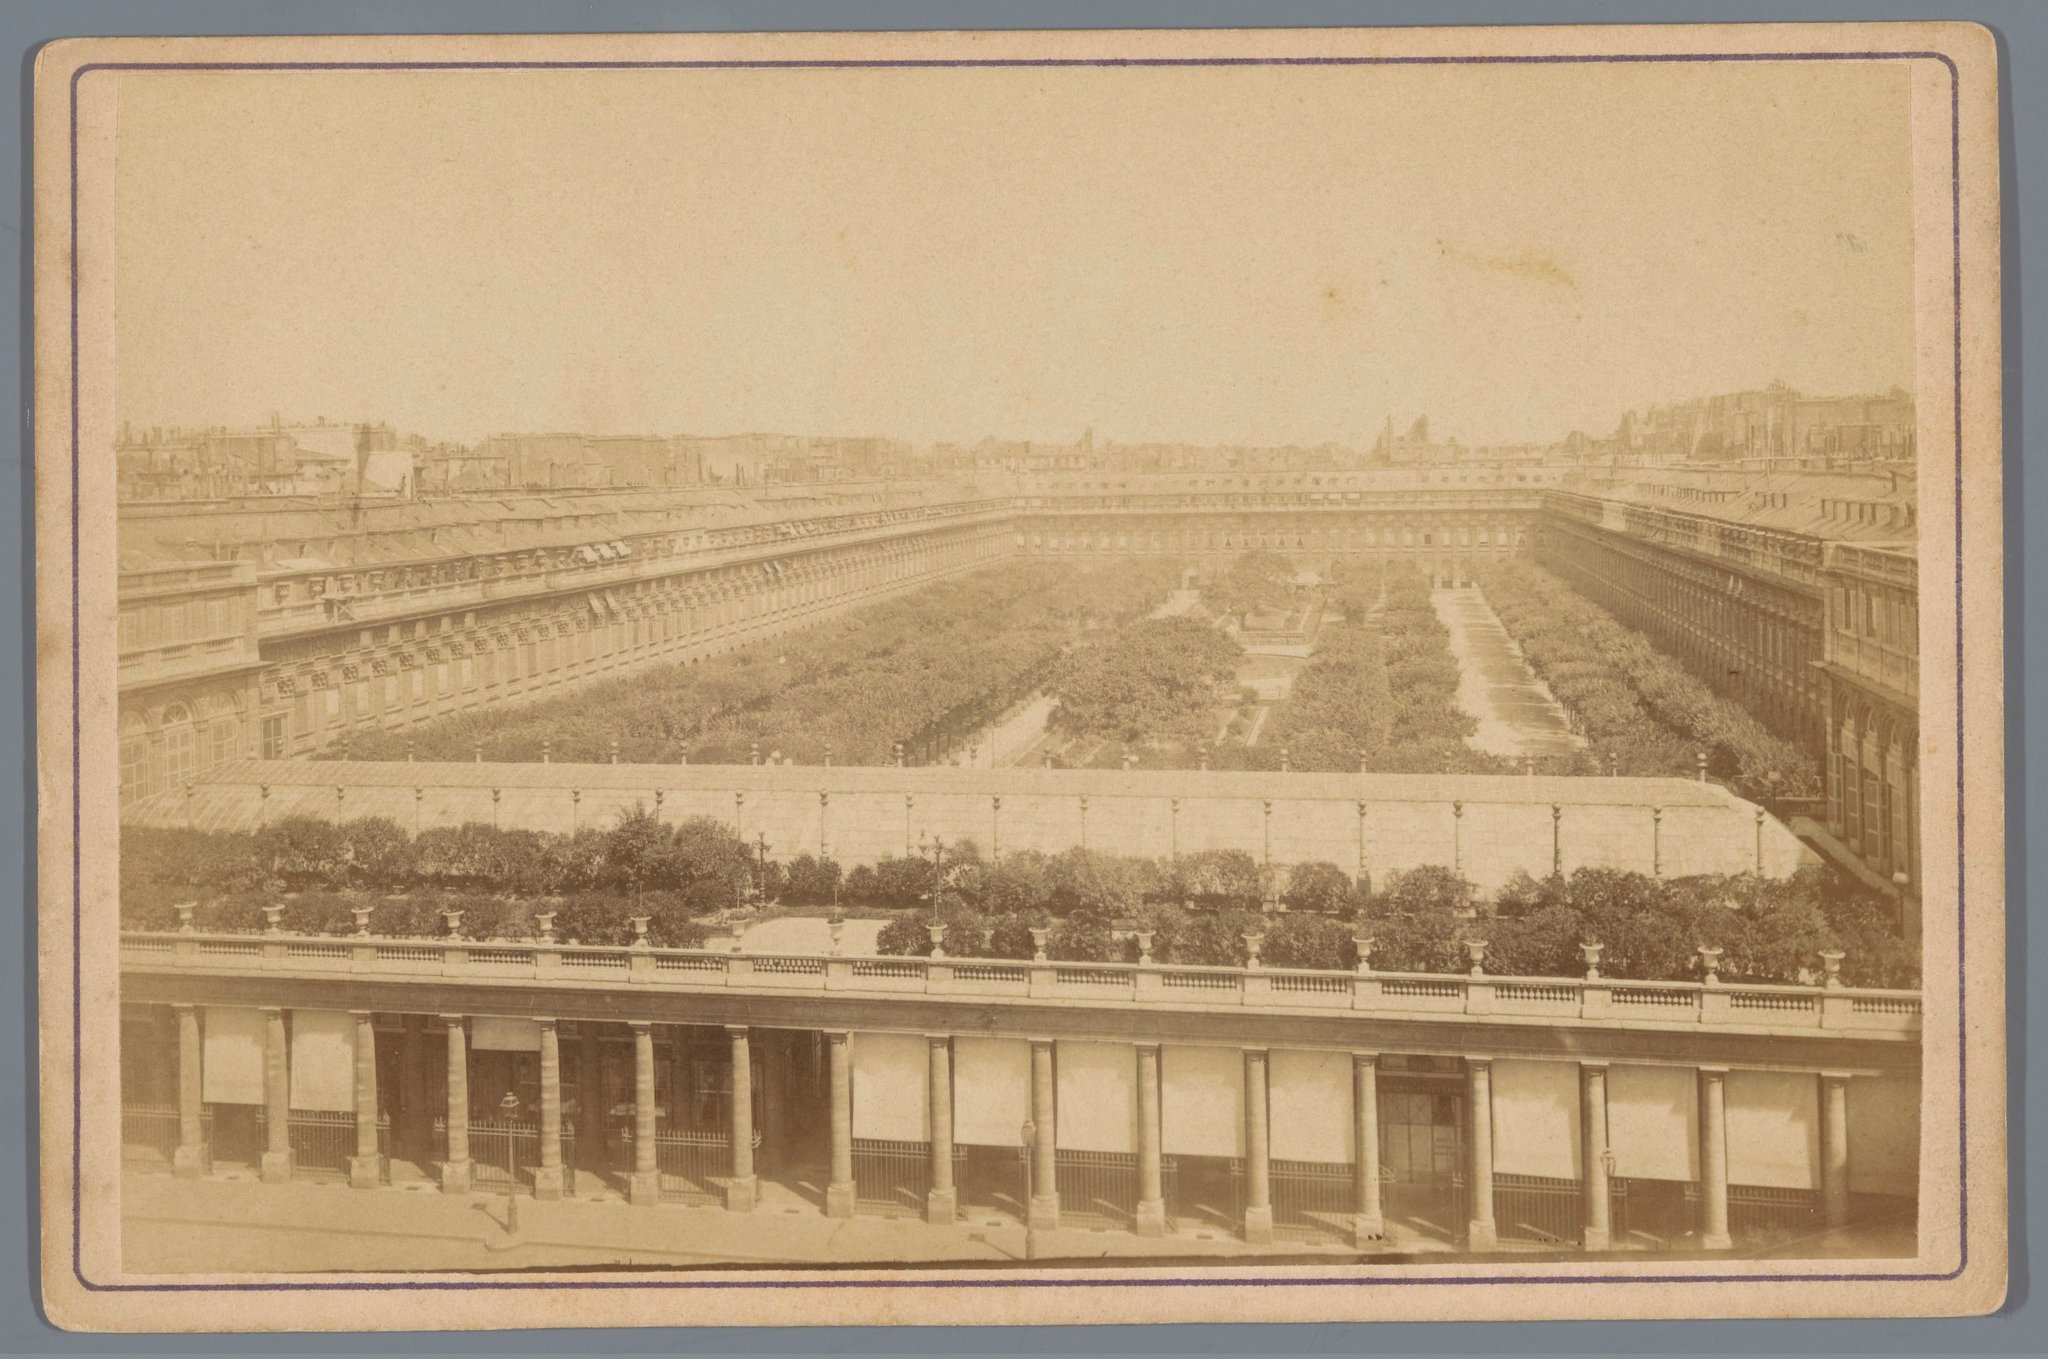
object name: cabinet photograph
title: Gezicht op de tuin van het Palais-Royal te Parijs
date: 1865-1875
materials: cardboard, photographic support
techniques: albumen print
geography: paris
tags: palace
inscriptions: inscription: ‘Compagnie Photographique Debitte & Hervé 170, Rue de Rivoli, Paris’, inscription: ‘Palais - Royal’